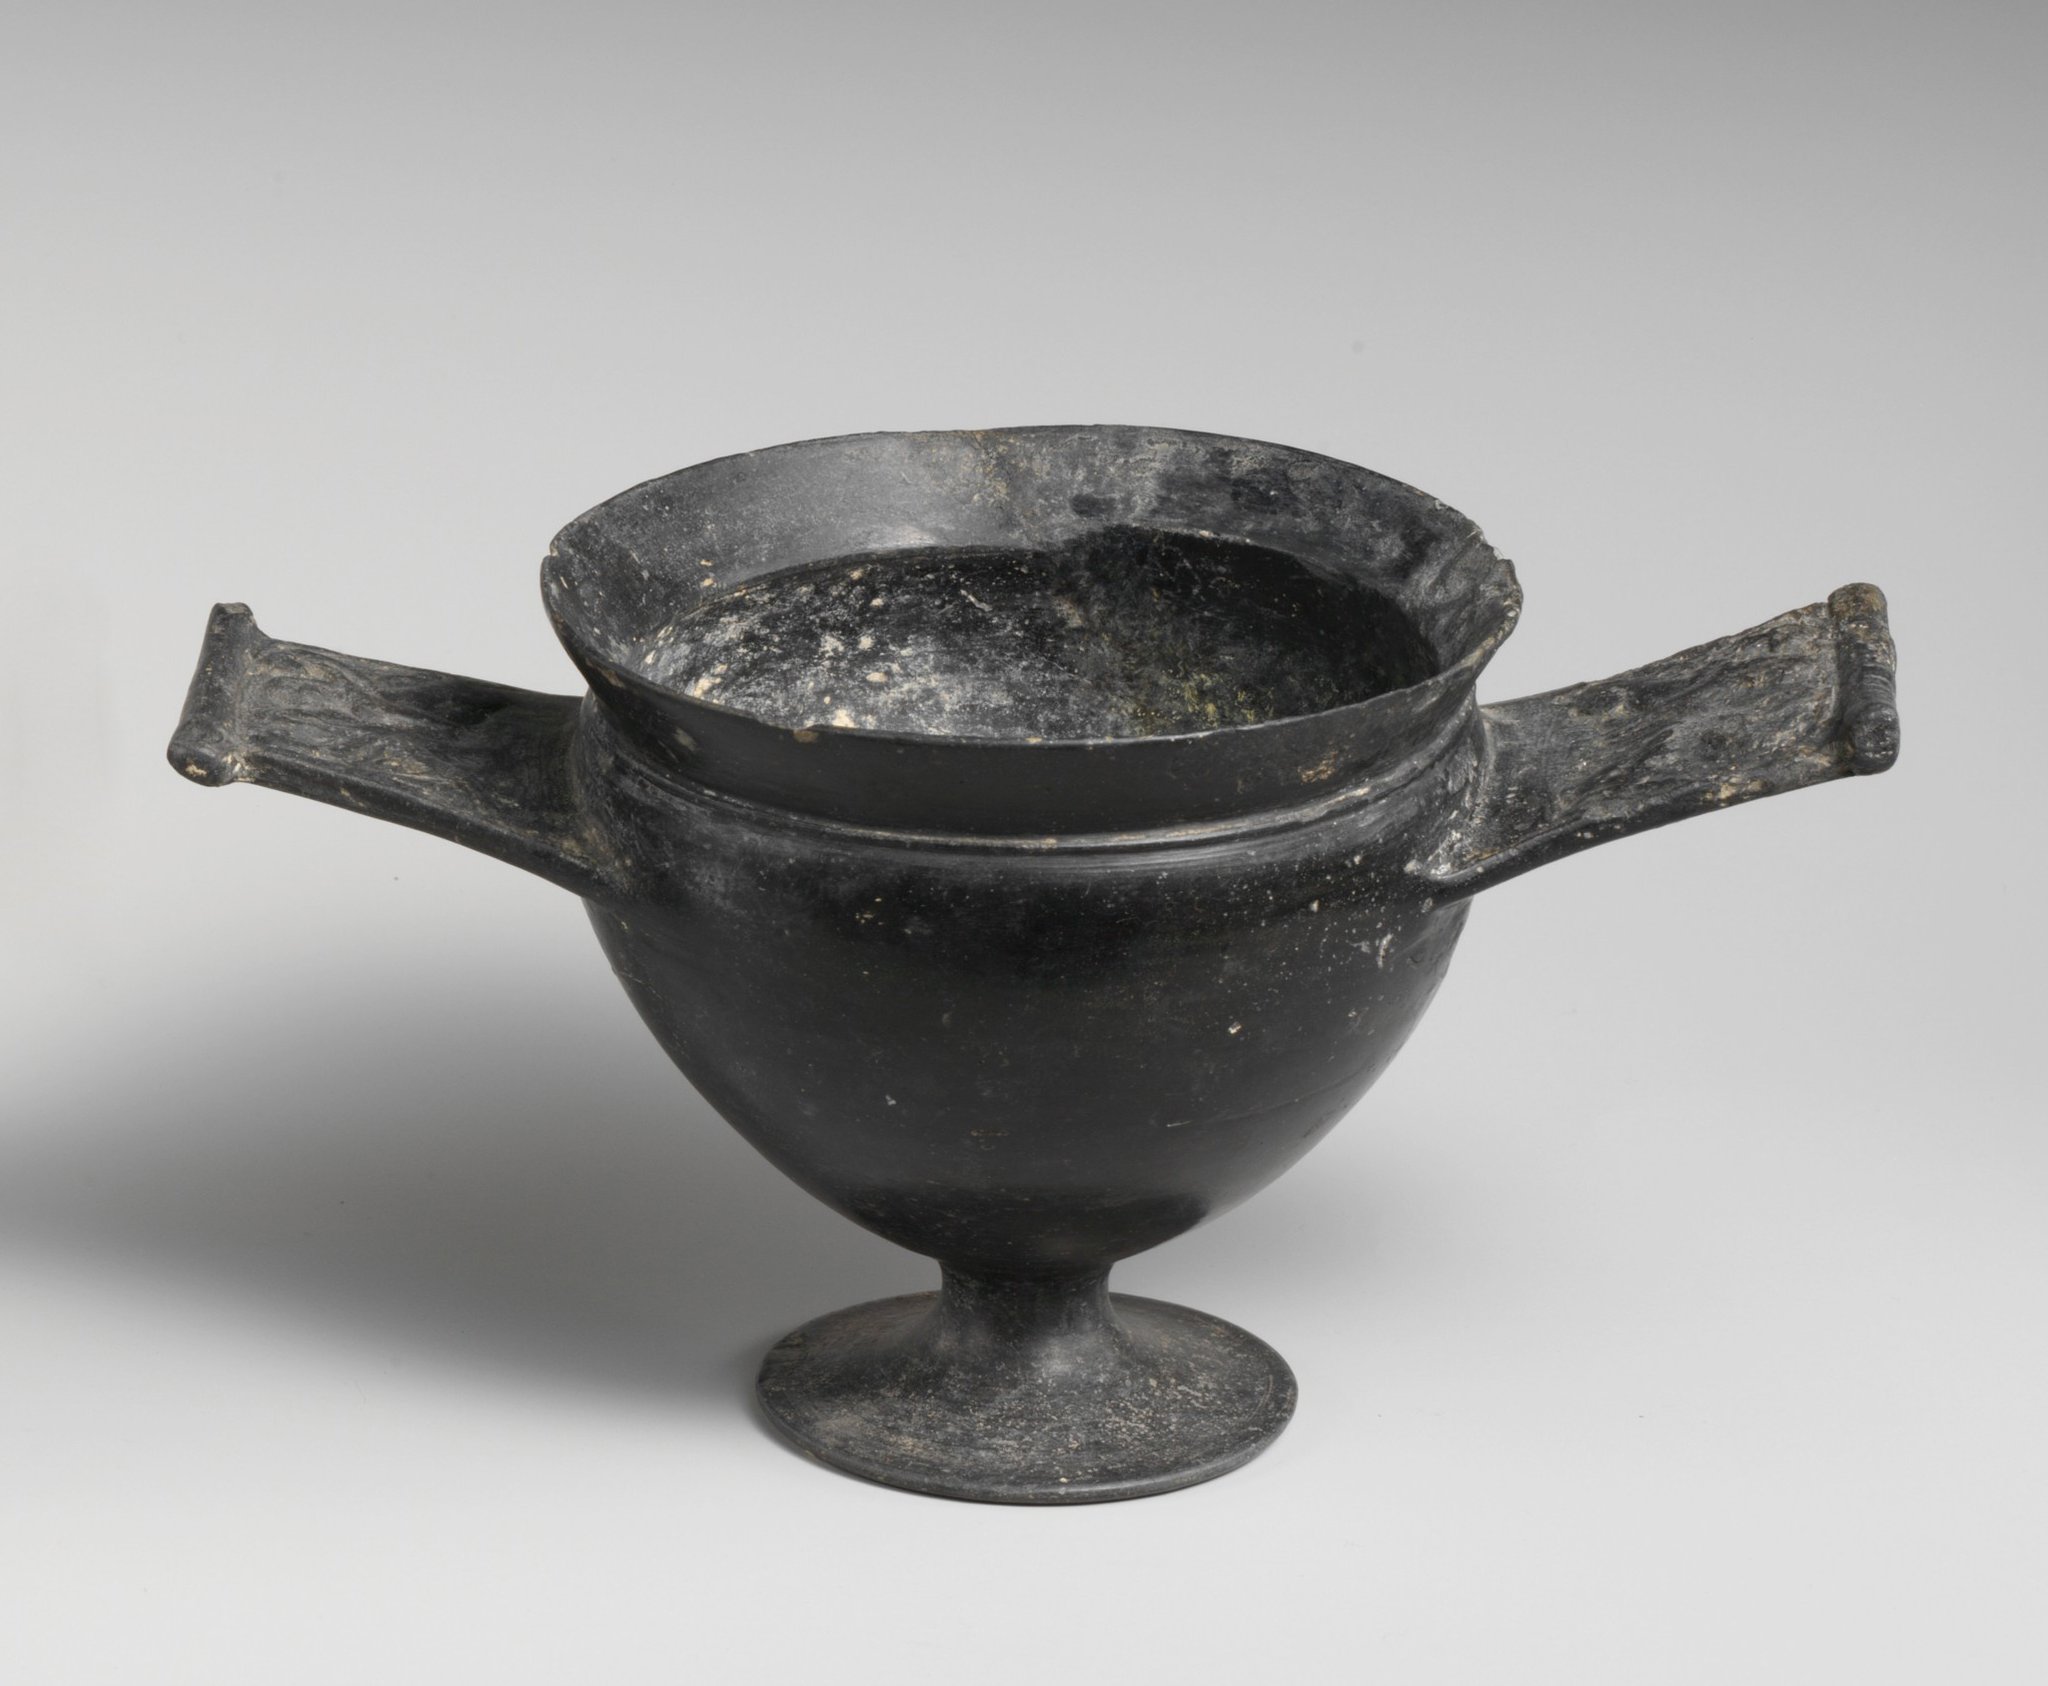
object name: cup with lid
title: Terracotta cup with lid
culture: etruscan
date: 650 BCE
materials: terracotta